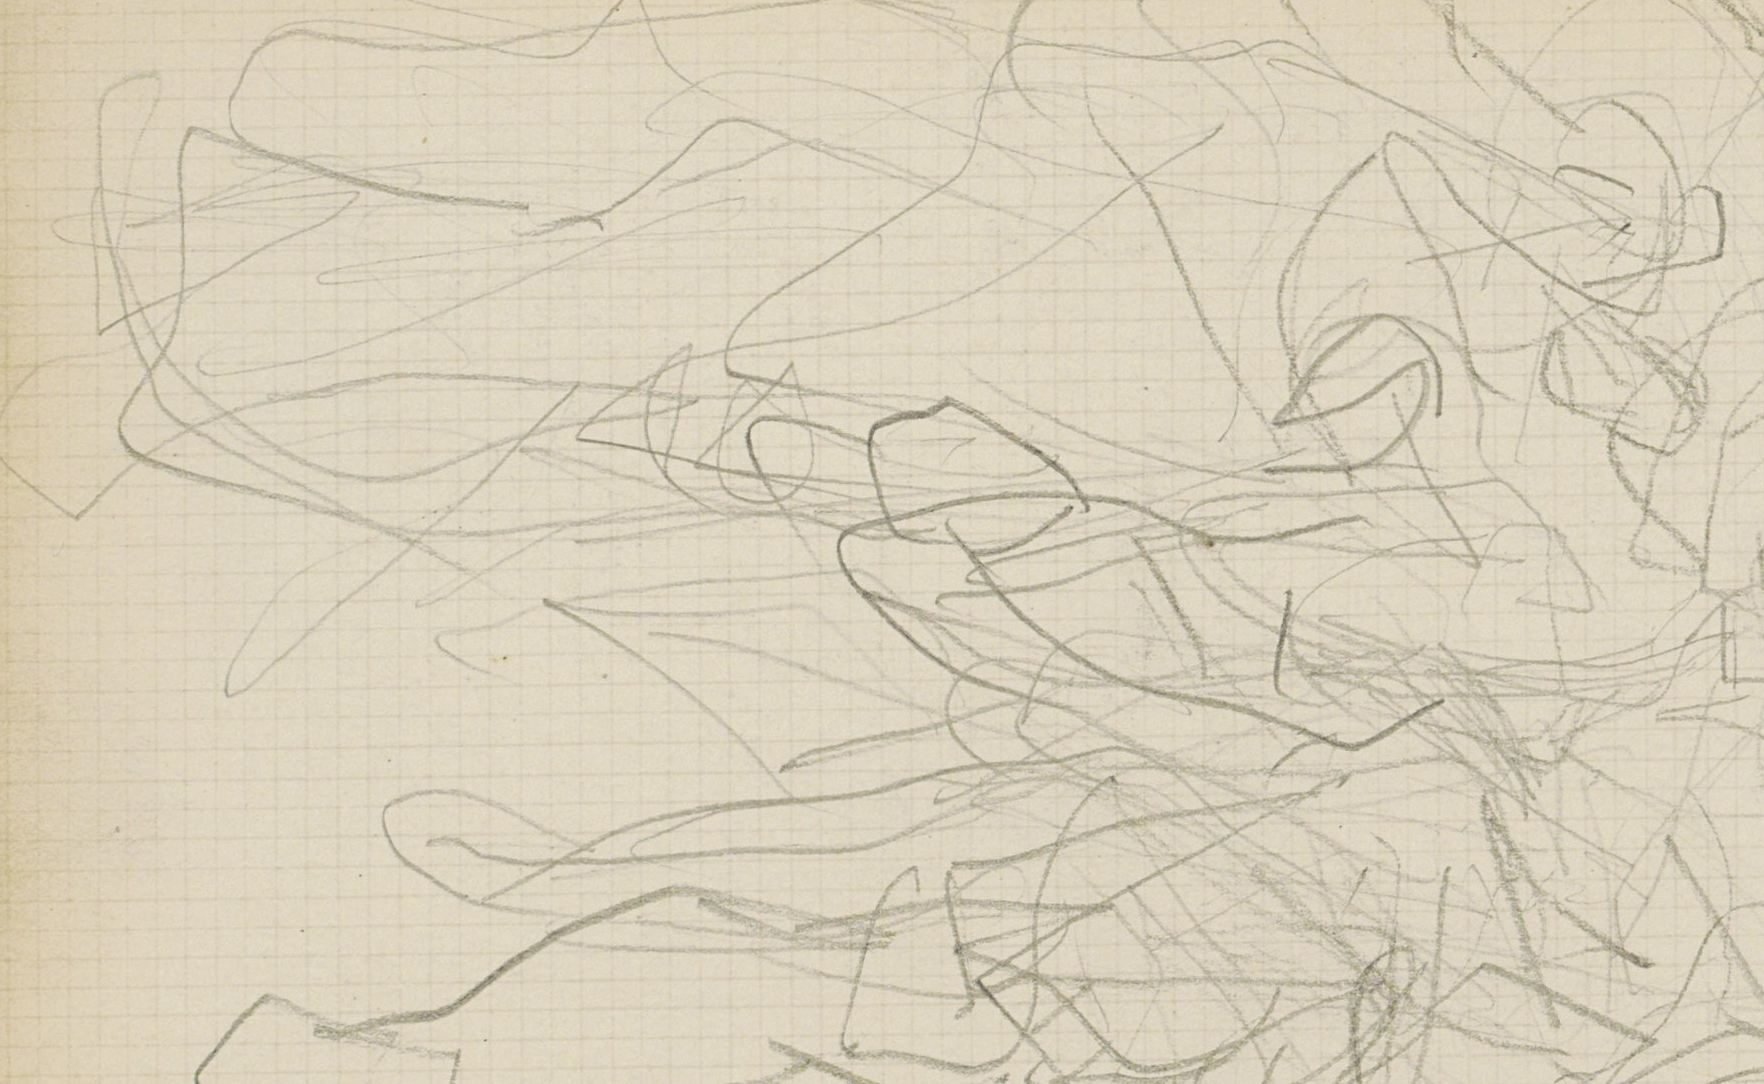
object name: sketchbook leaf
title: Man en vrouw, de hoofden naar elkaar gebogen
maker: matthijs maris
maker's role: draughtsman, painter, print maker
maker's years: 1839-1917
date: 1849-1917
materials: pencil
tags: adult woman, adult man, head turned sideways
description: Blad 19 verso uit een schetsboek met 35 bladen.